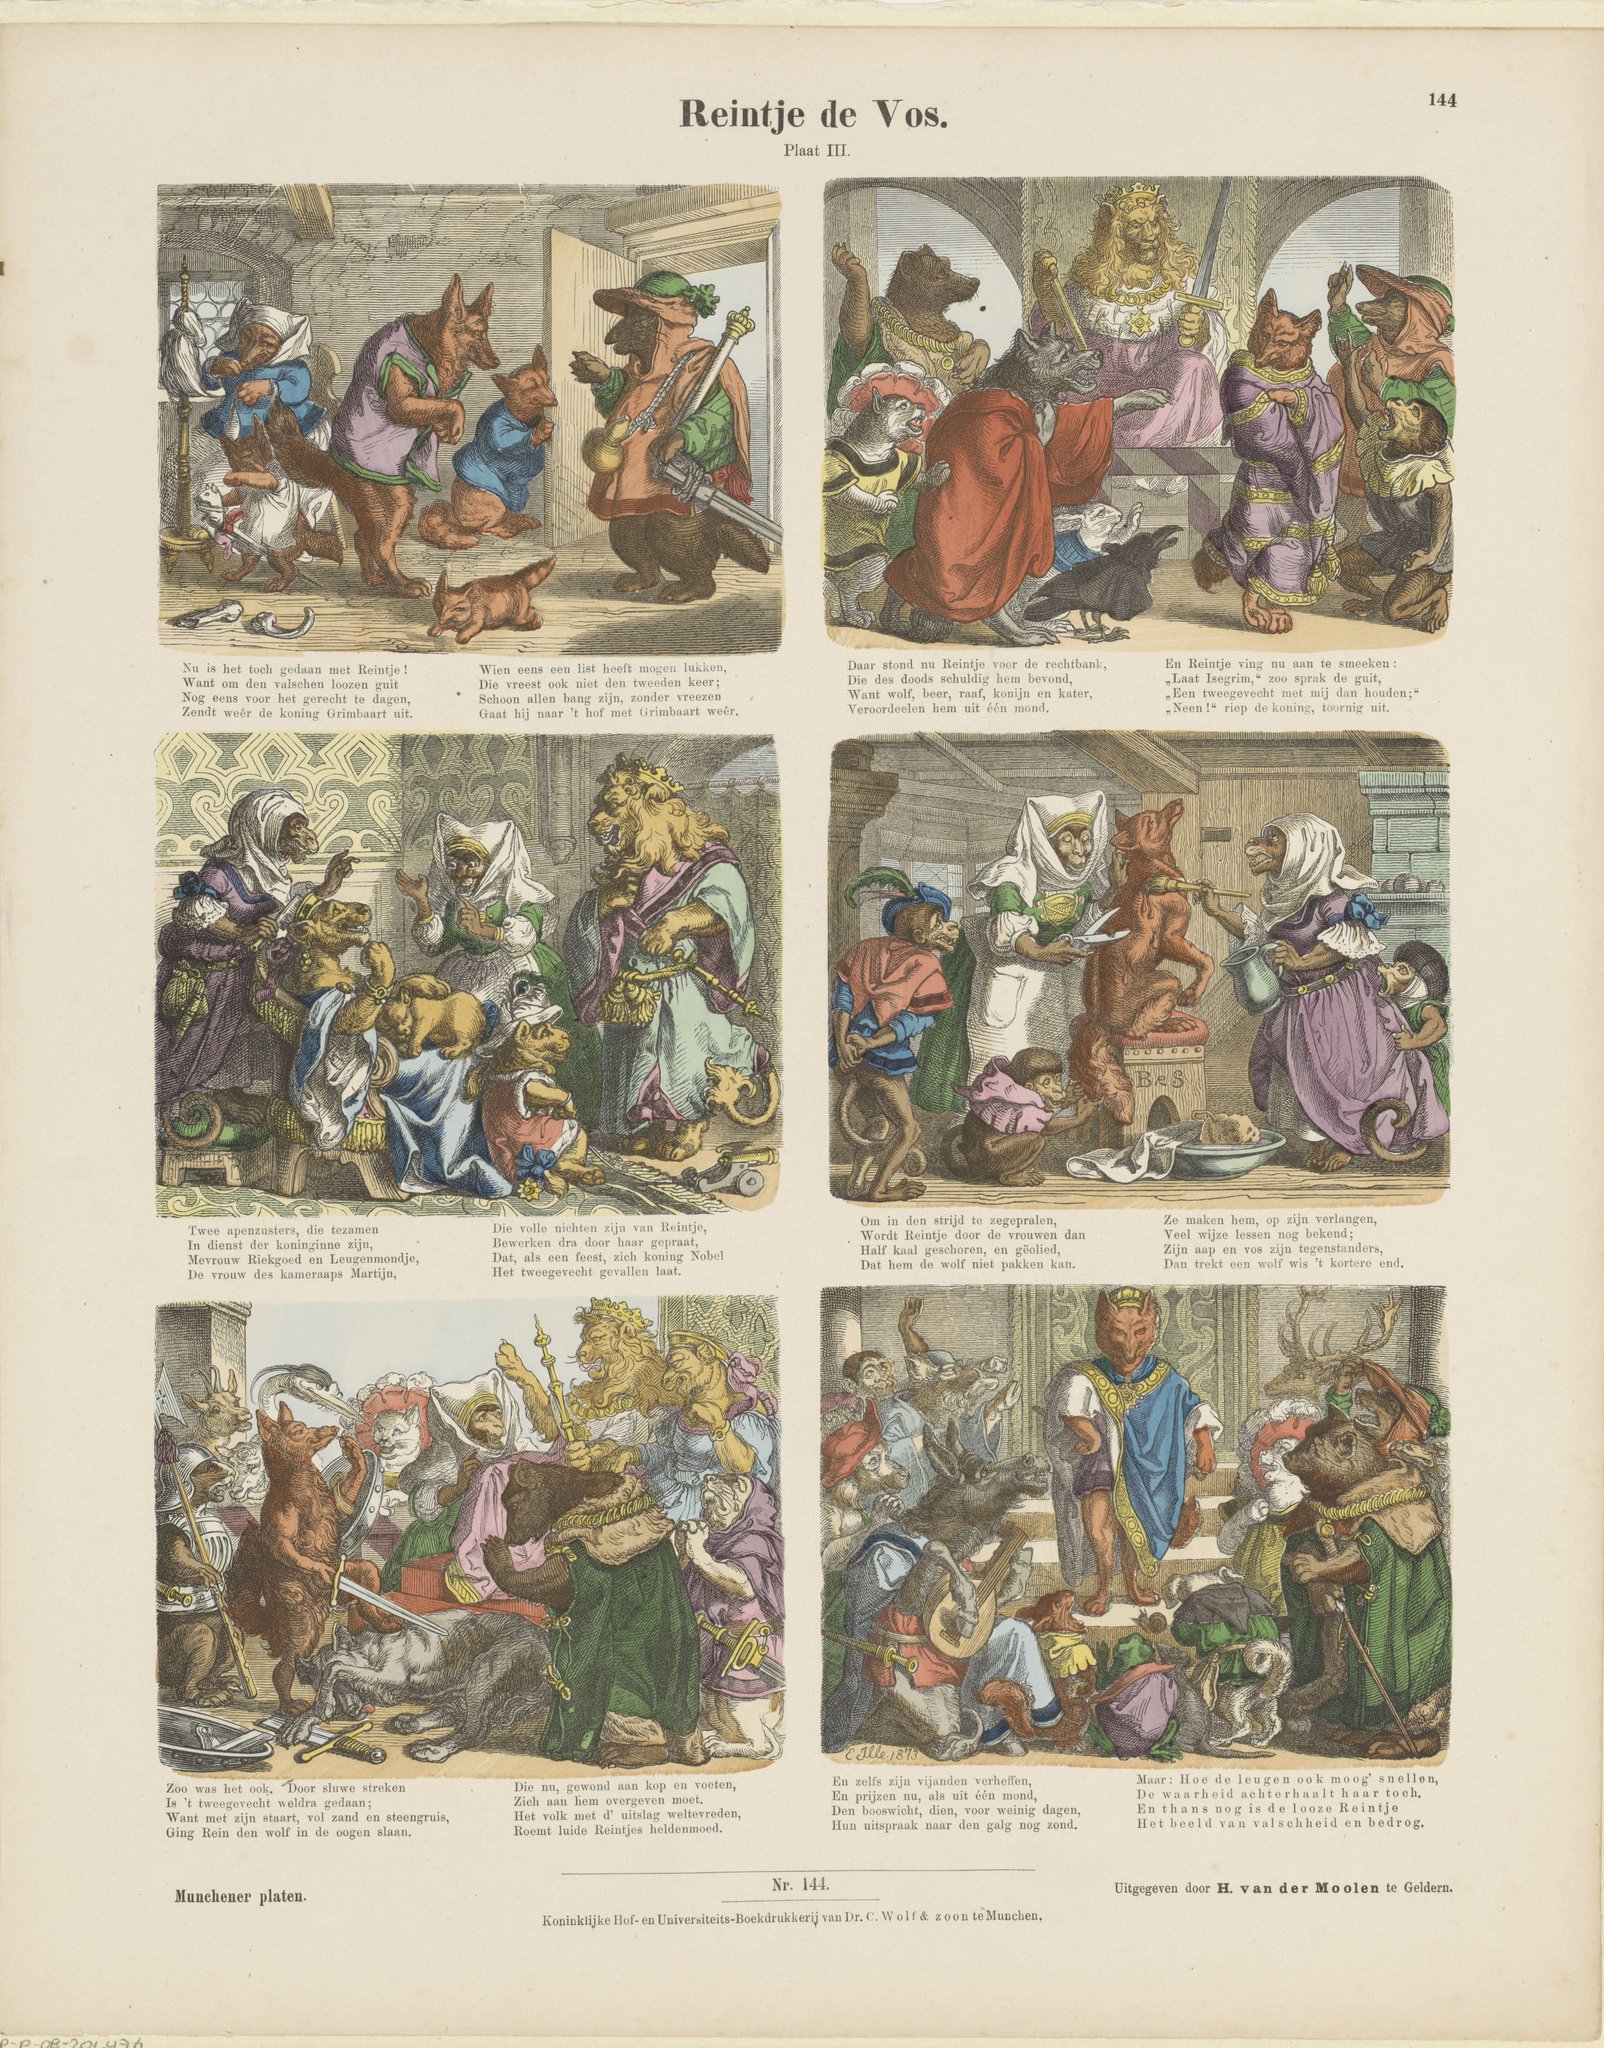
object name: print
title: Reintje de Vos. / Plaat III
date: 1873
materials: paper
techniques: colour, letterpress printing, engraving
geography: munich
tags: fable of reynard the fox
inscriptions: collector's mark: Lugt 2760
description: Blad met 6 voorstellingen uit het epos van Reinaert de vos. Onder elke afbeelding een achtregelig vers in twee kolommen. Genummerd midden onder: Nro. 144. Genummerd rechtsboven: 144.